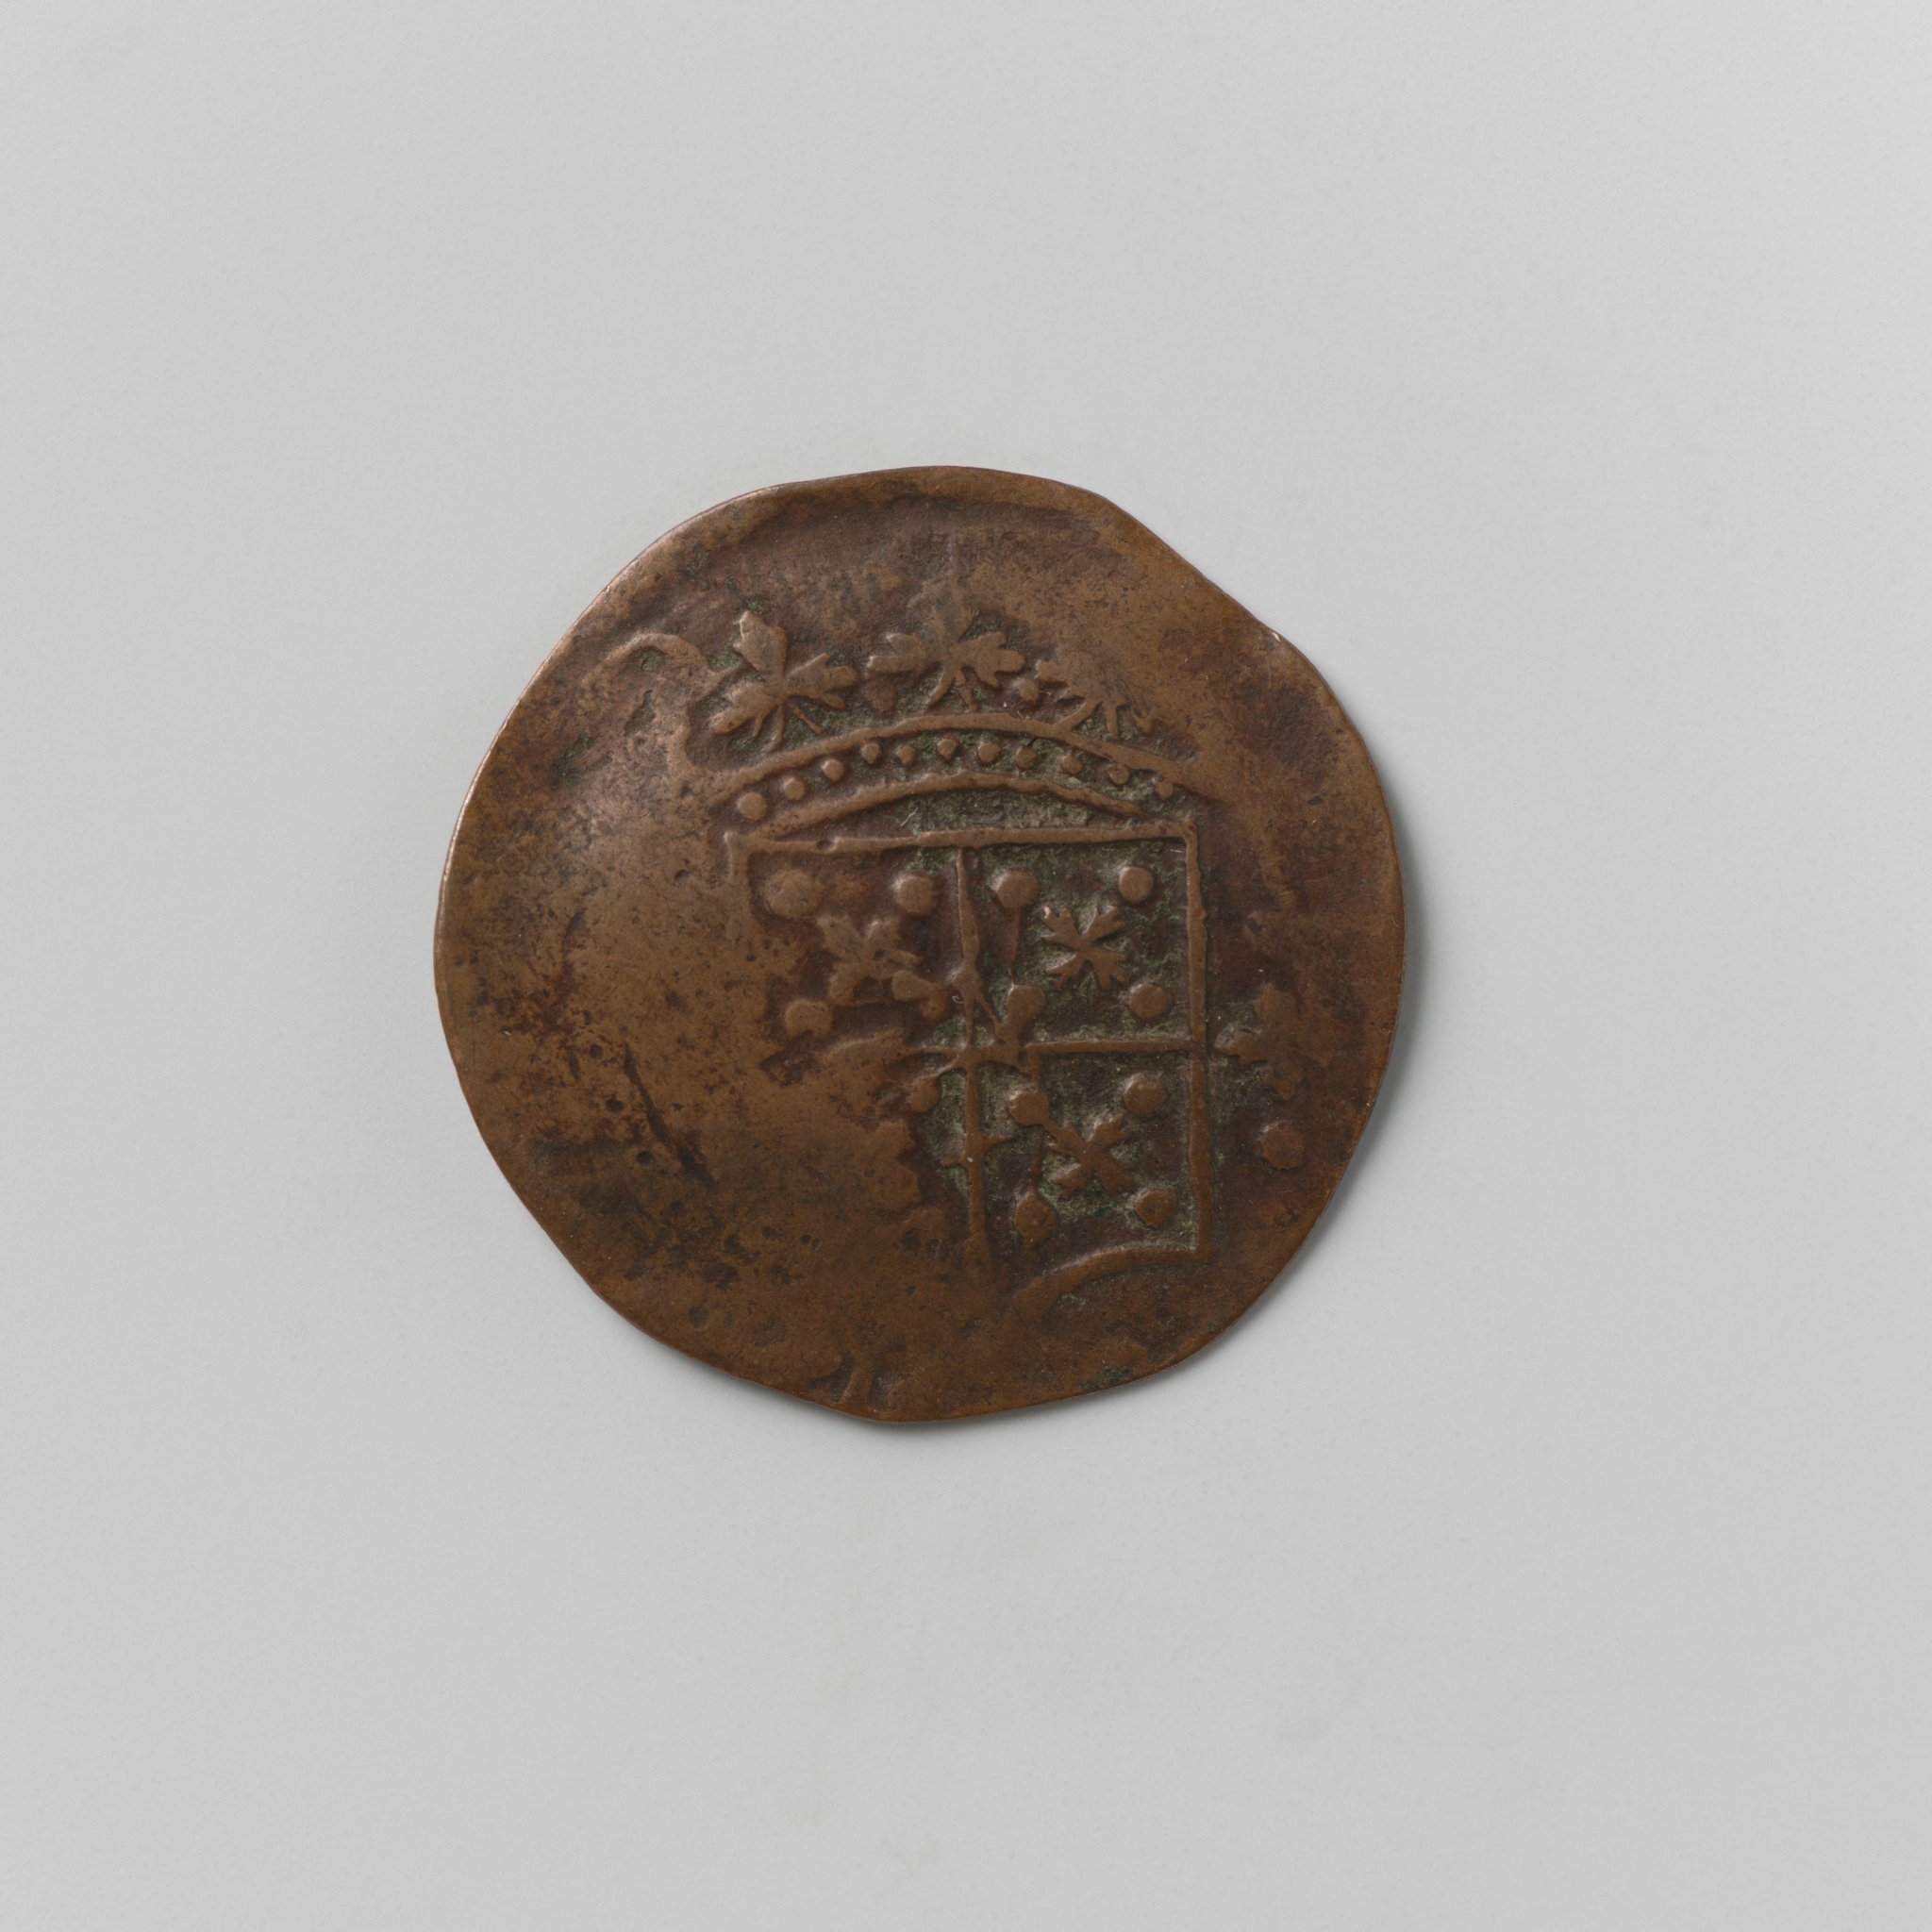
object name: coin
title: Nabootsing van een koperen munt uit Bombay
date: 1780-1830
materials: copper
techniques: striking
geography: banjarmasin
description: Koperen munt. Nabootsing van een koperen munt uit Bombay. Voorzijde: gekroond en versierd fictief wapenschild. Keerzijde: bovenste gedeelte van een weegschaal.